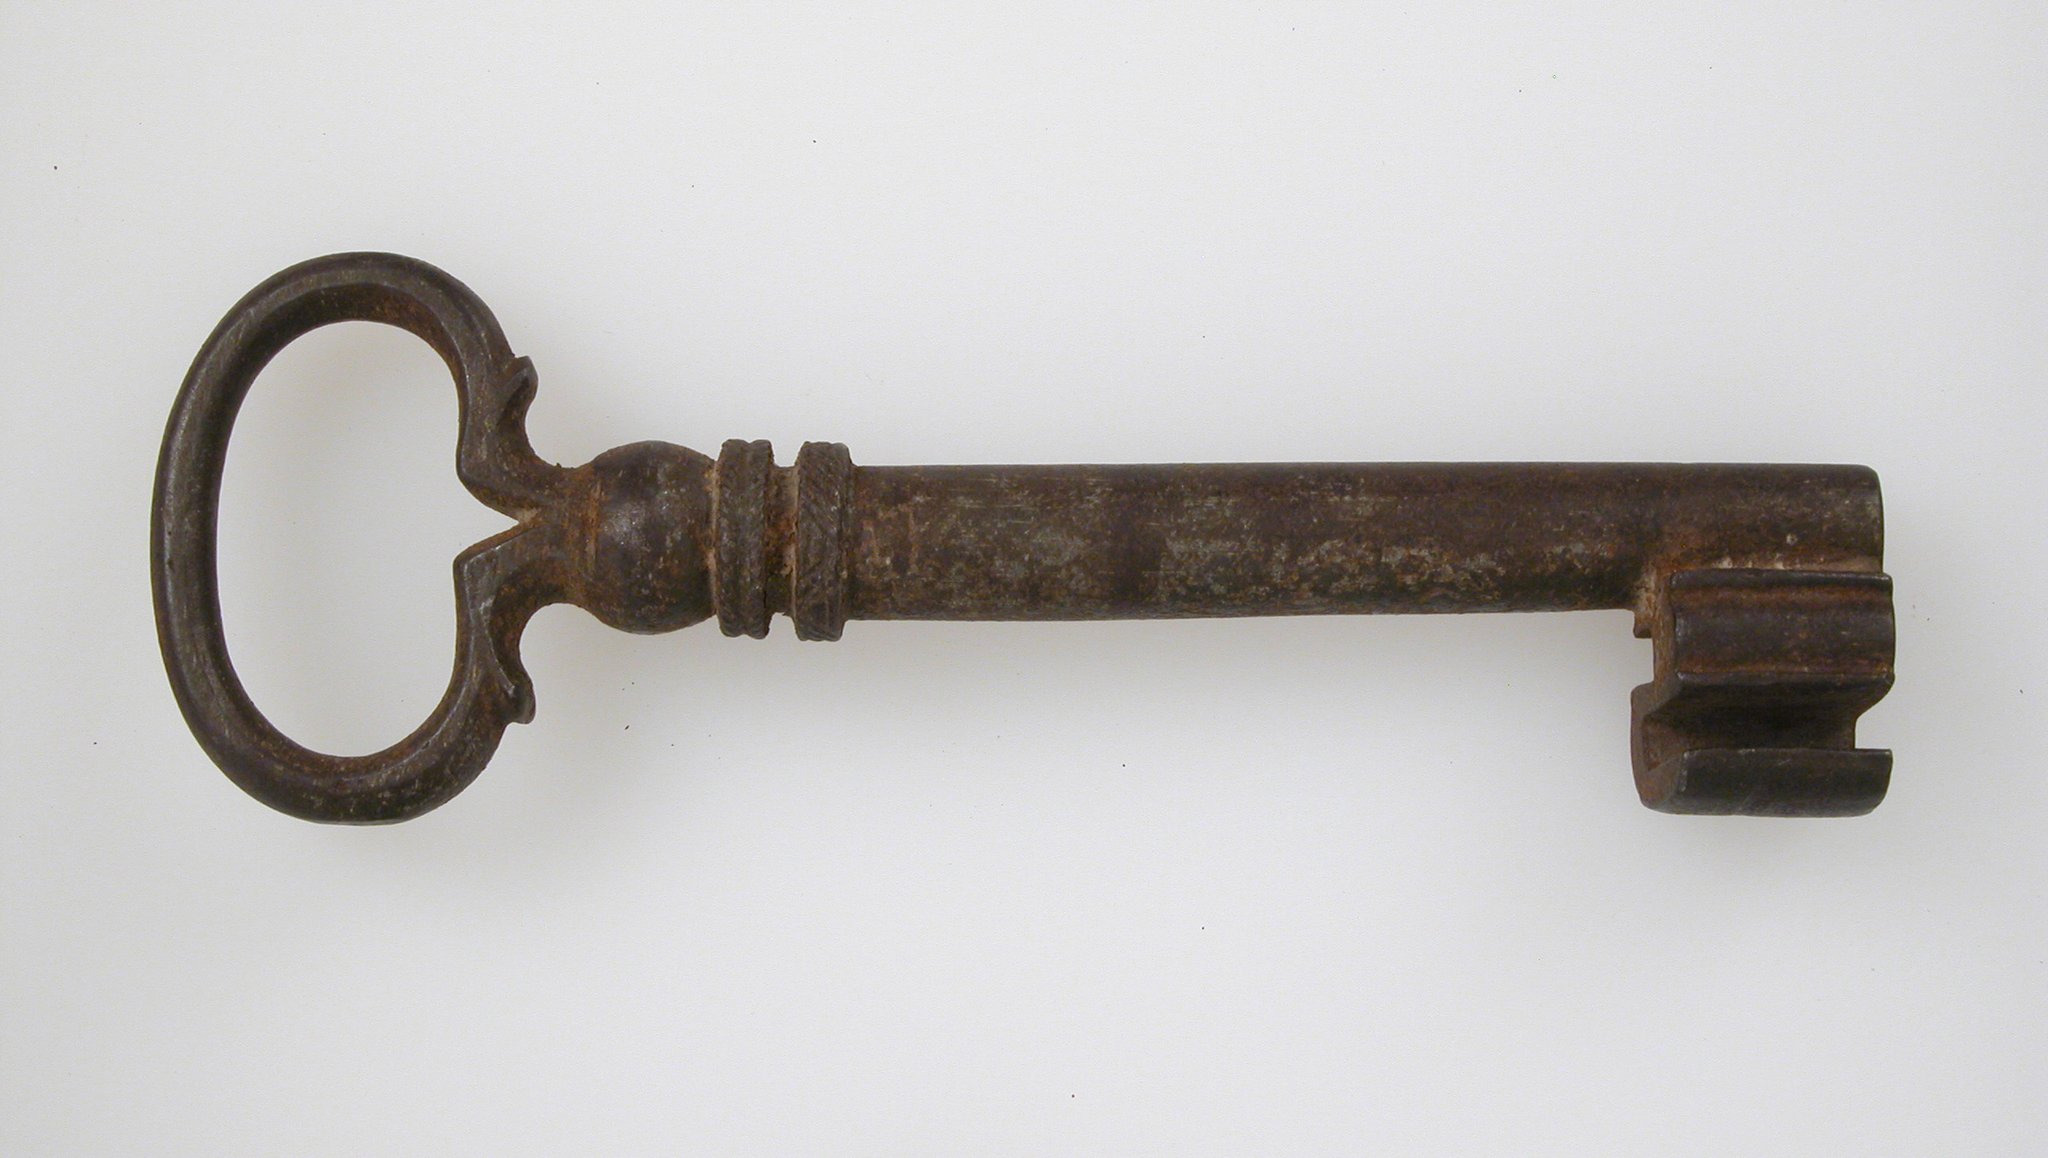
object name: key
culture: german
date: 1401-1600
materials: iron